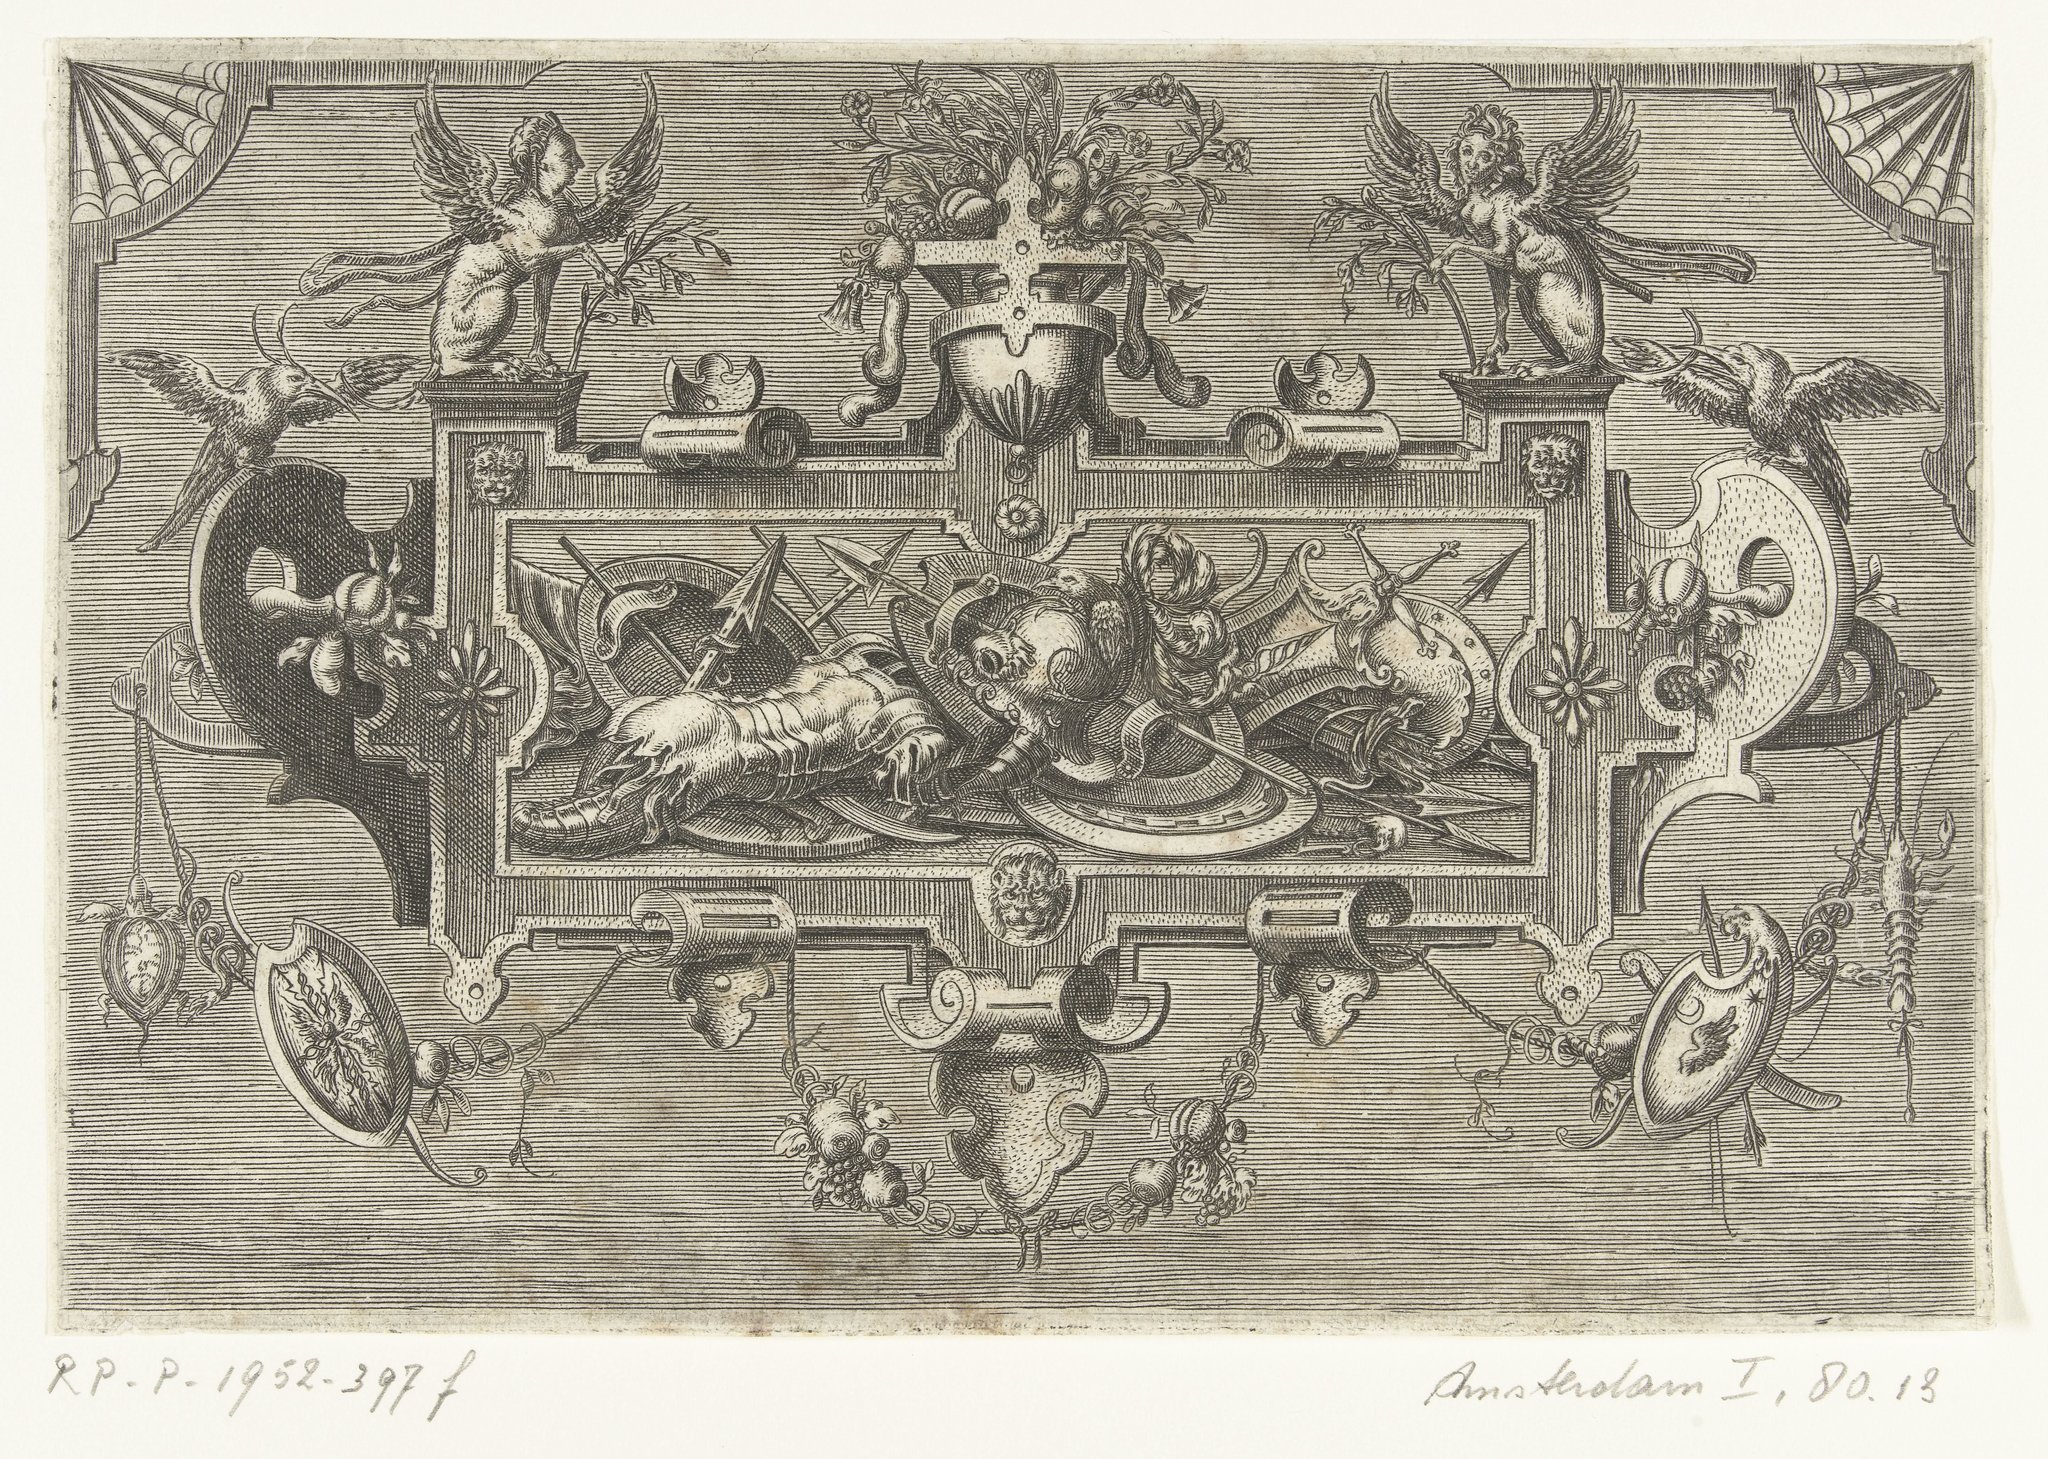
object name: ornament print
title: Cartouche met een wapentrofee in een omlijsting van rolwerk, daarboven twee sfinxen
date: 1564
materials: paper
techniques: engraving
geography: antwerp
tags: sphinx (lion/woman); 'sfinge' (ripa) - aa - female human figure, trophy, i.e.: decorative arrangement of symbolic or typical objects ~ ornament, tortoises, turtles, ornament ~ cartouche, crustaceans: lobster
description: Cartouche met een wapentrofee in een omlijsting van rolwerk. Op de cartouche zit links en rechts een sfinx. Tussen hen in een grote vaas met bloemen en fruit. Onderaan een wapenschild met boog en een wapenschild met pijl. Links en rechts daarvan een schildpad en een kreeft.